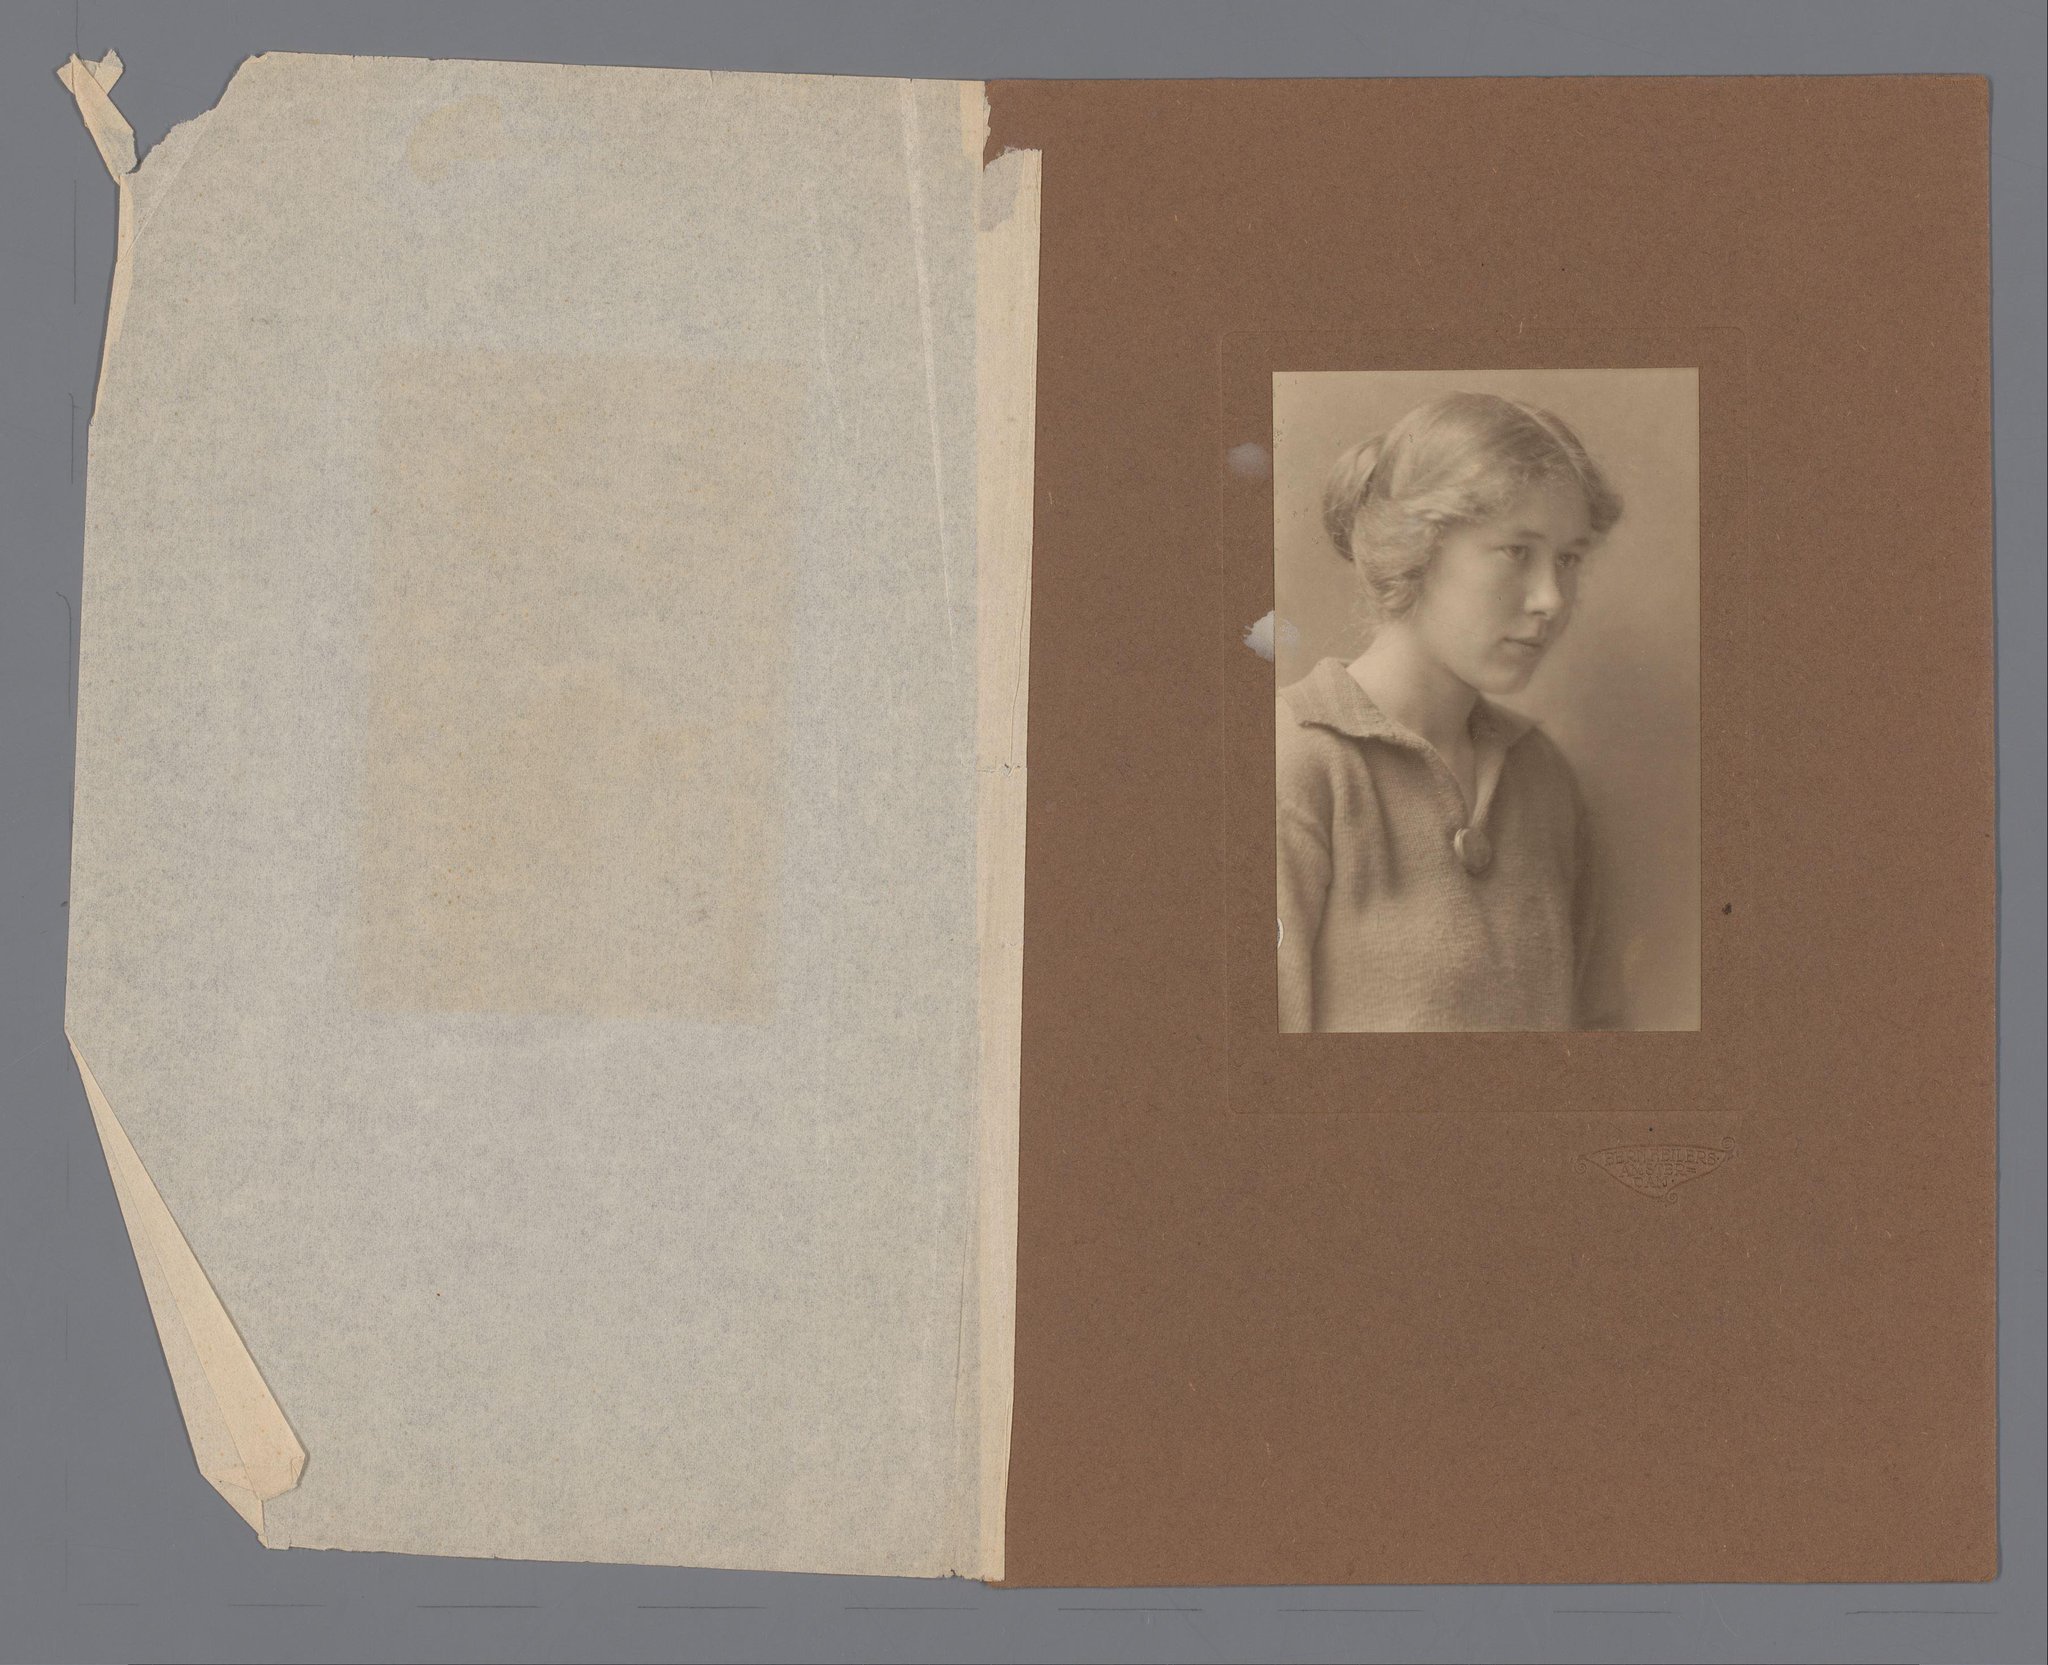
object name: photograph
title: Portret van een jonge vrouw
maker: bernard eilers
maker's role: fotograaf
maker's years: 1878-1951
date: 1900-1930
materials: cardboard, photographic support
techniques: gelatin silver print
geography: amsterdam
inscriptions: check stamp: ‘BERN.F.EILERS.//AMSTER-//DAM.’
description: Portret van een jonge vrouw met blond, opgestoken haar, naar rechts kijkend.